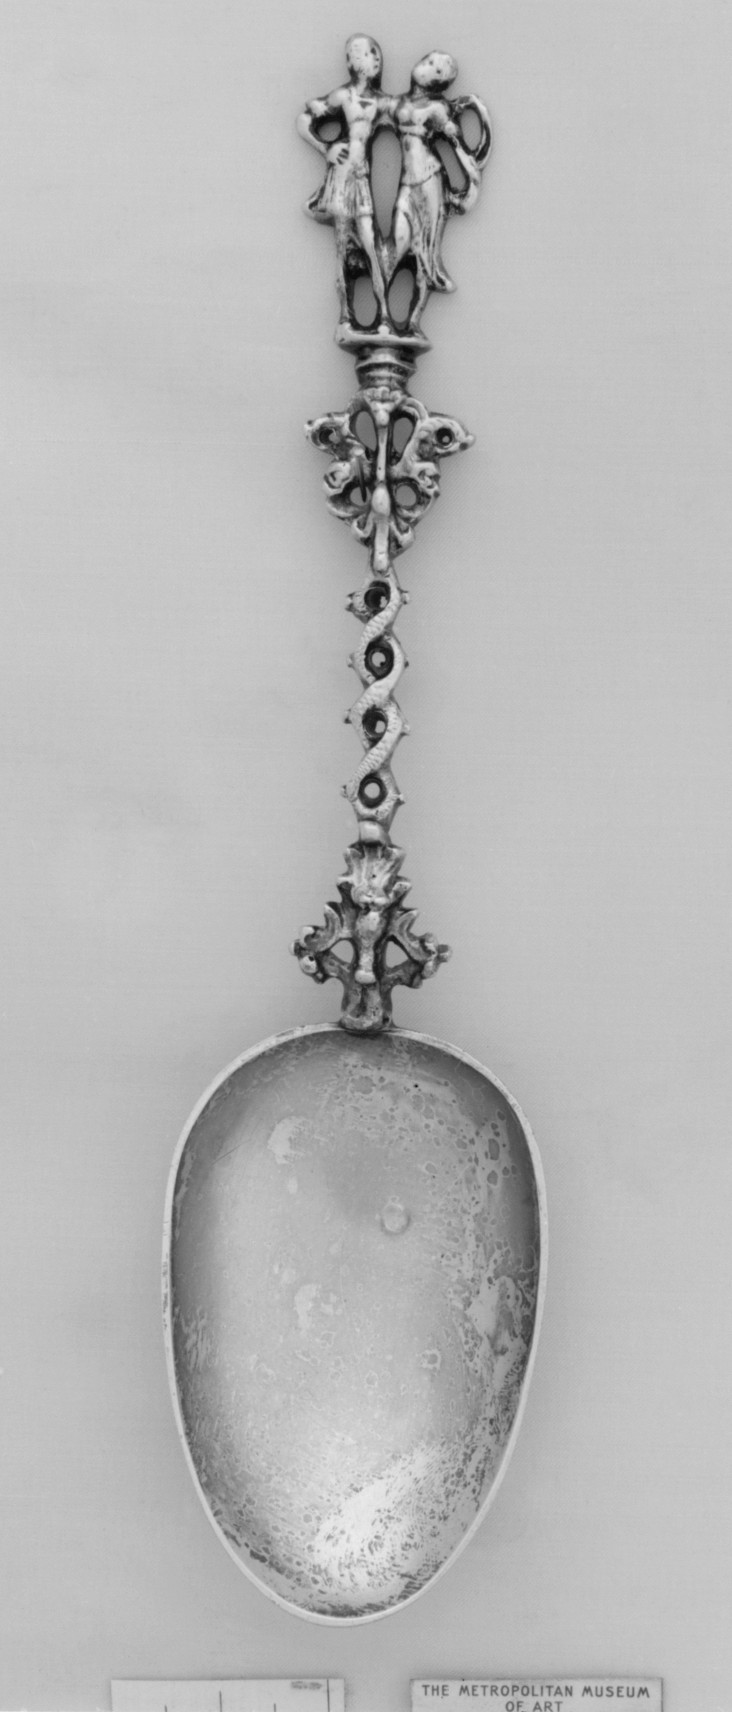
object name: spoon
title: Figure-top spoon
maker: johannes andringa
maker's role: maker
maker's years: 1722-1769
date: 1734-1766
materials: silver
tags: men,women